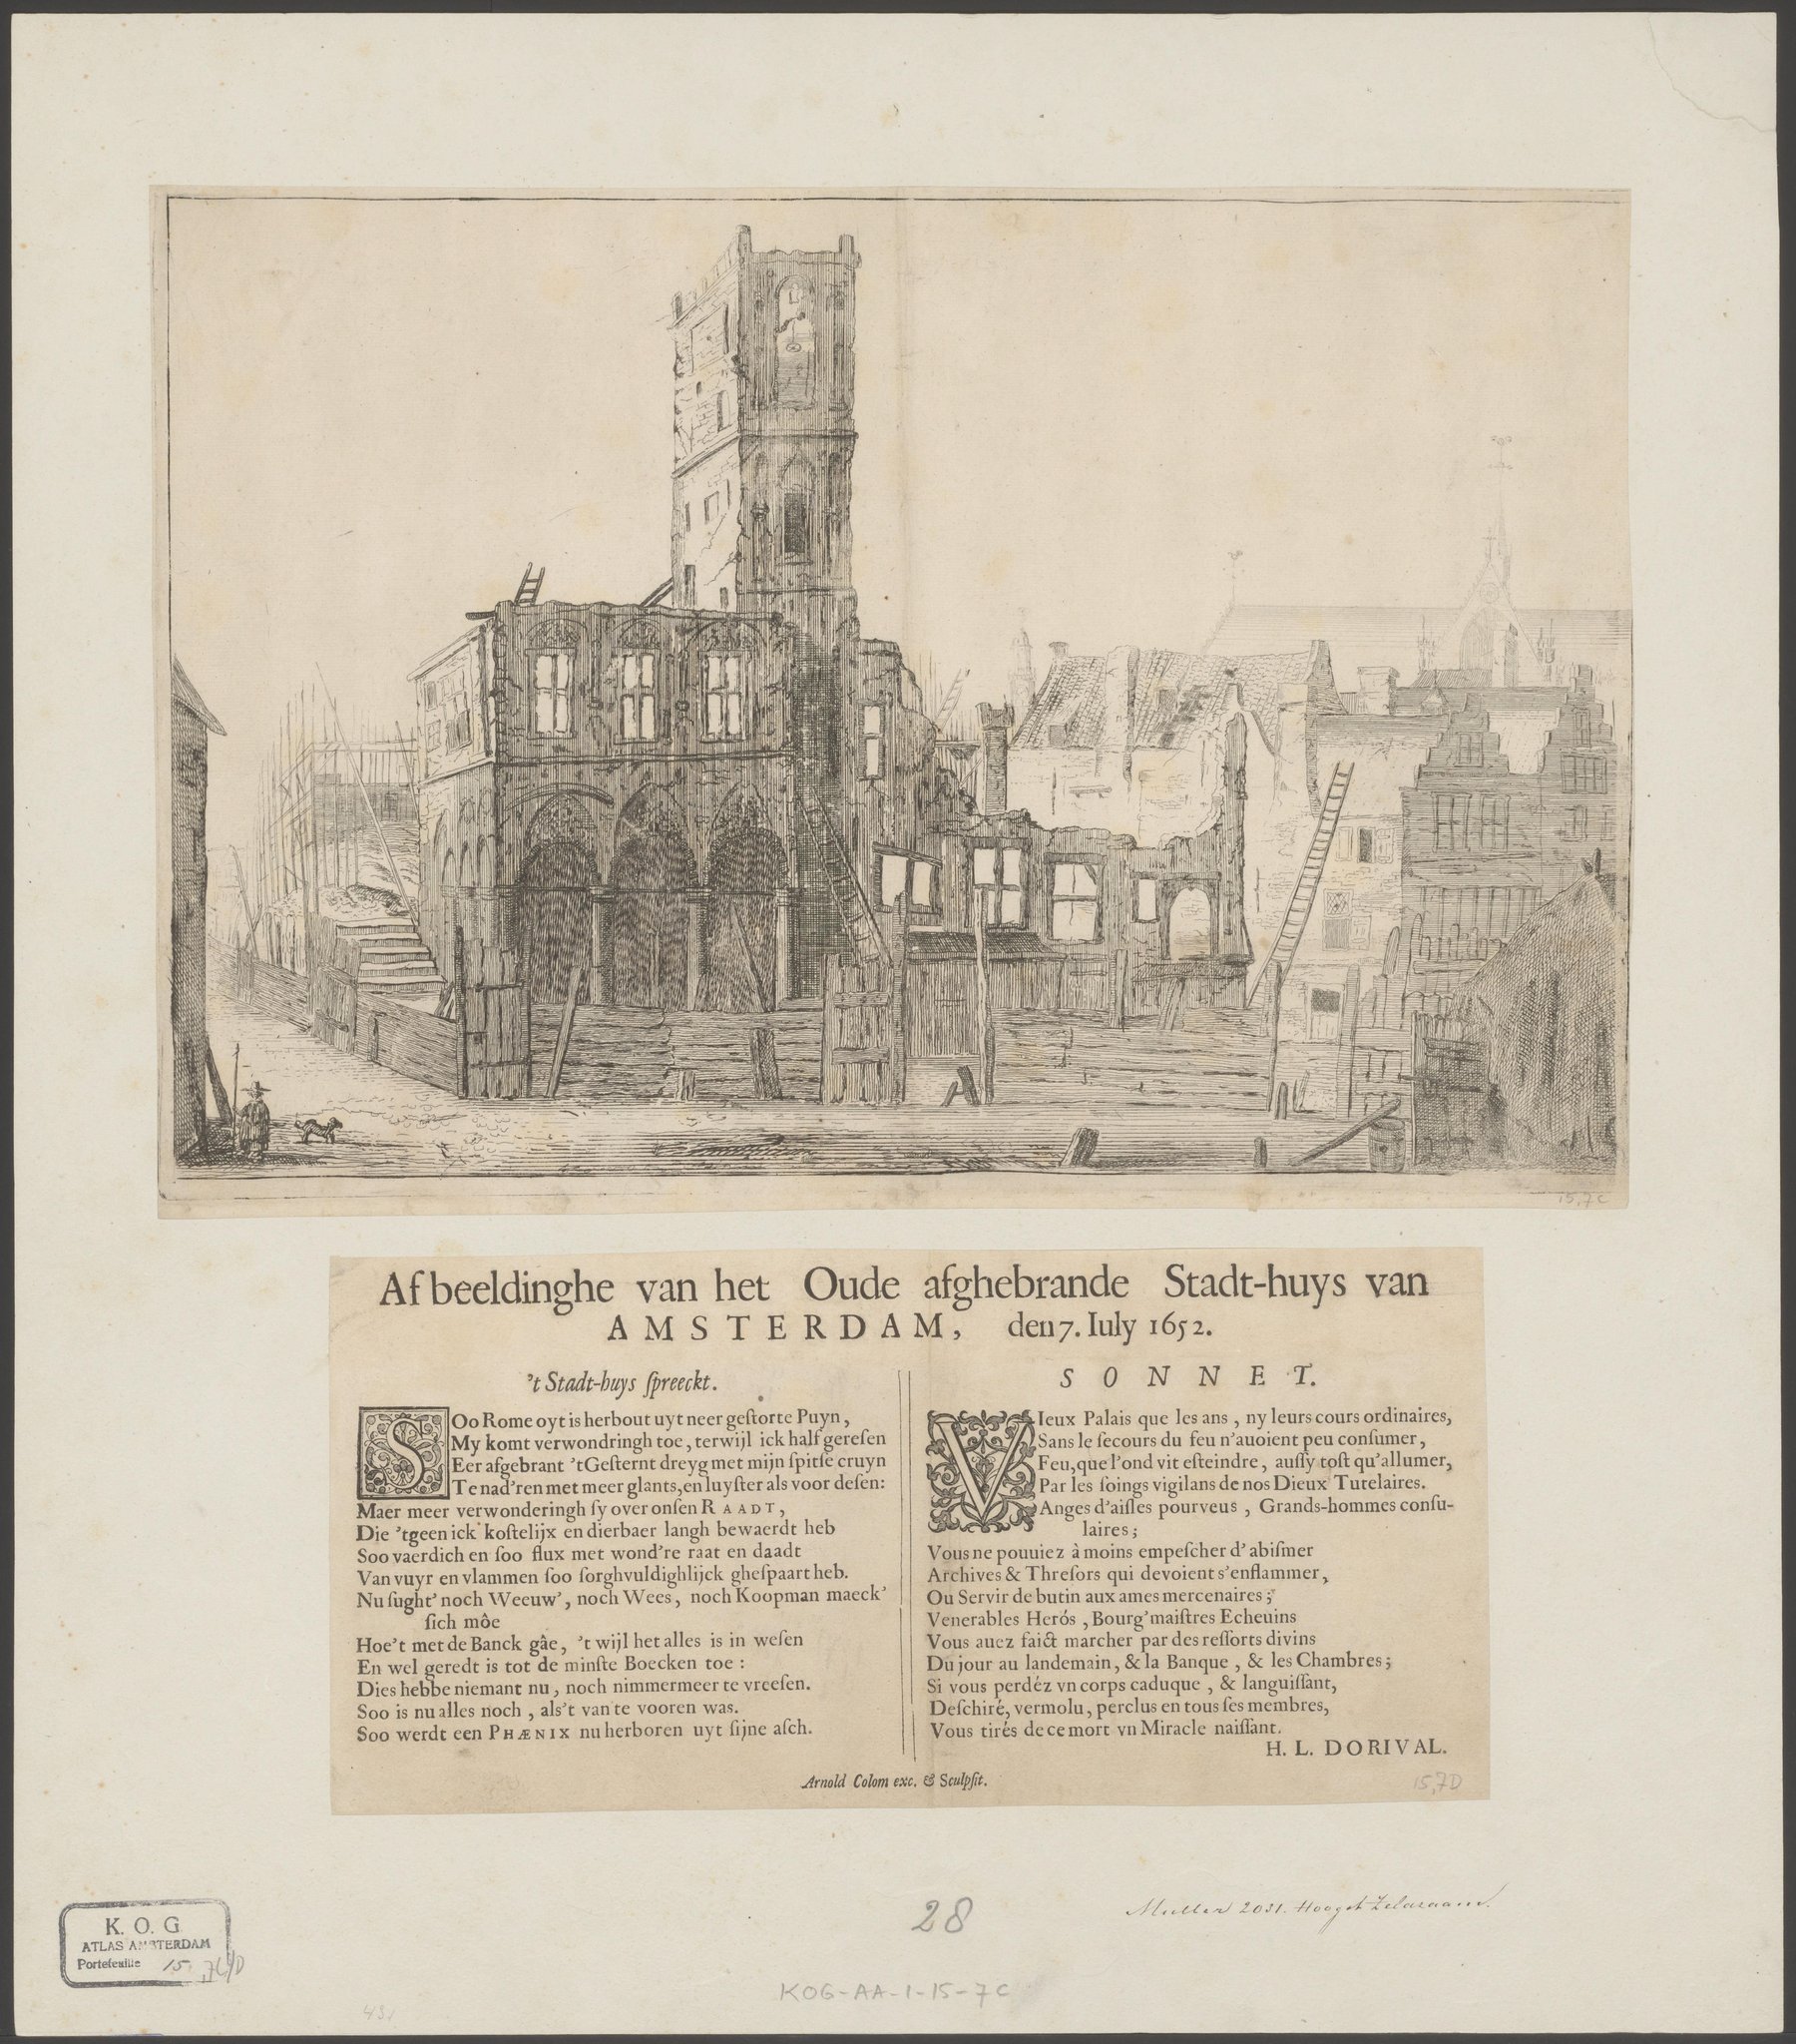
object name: print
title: Gezicht op de ruïne van het oude stadhuis van Amsterdam met tekstblad met verzen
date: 1652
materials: paper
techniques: etching, letterpress printing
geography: amsterdam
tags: city-view in general; 'veduta', townhall, ruin of a dwelling, house, castle, etc.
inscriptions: collector's mark: ‘15, 7C/D’ Lugt 1641b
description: Prent uit: Rademaker, Abraham. Kabinet van Nederlandsche outheden en gezichten: vervat in 300 konstplaaten (…). 2 delen. Amsterdam: Willem Barents, 1725, dl. 1, ill. 15 en 16.